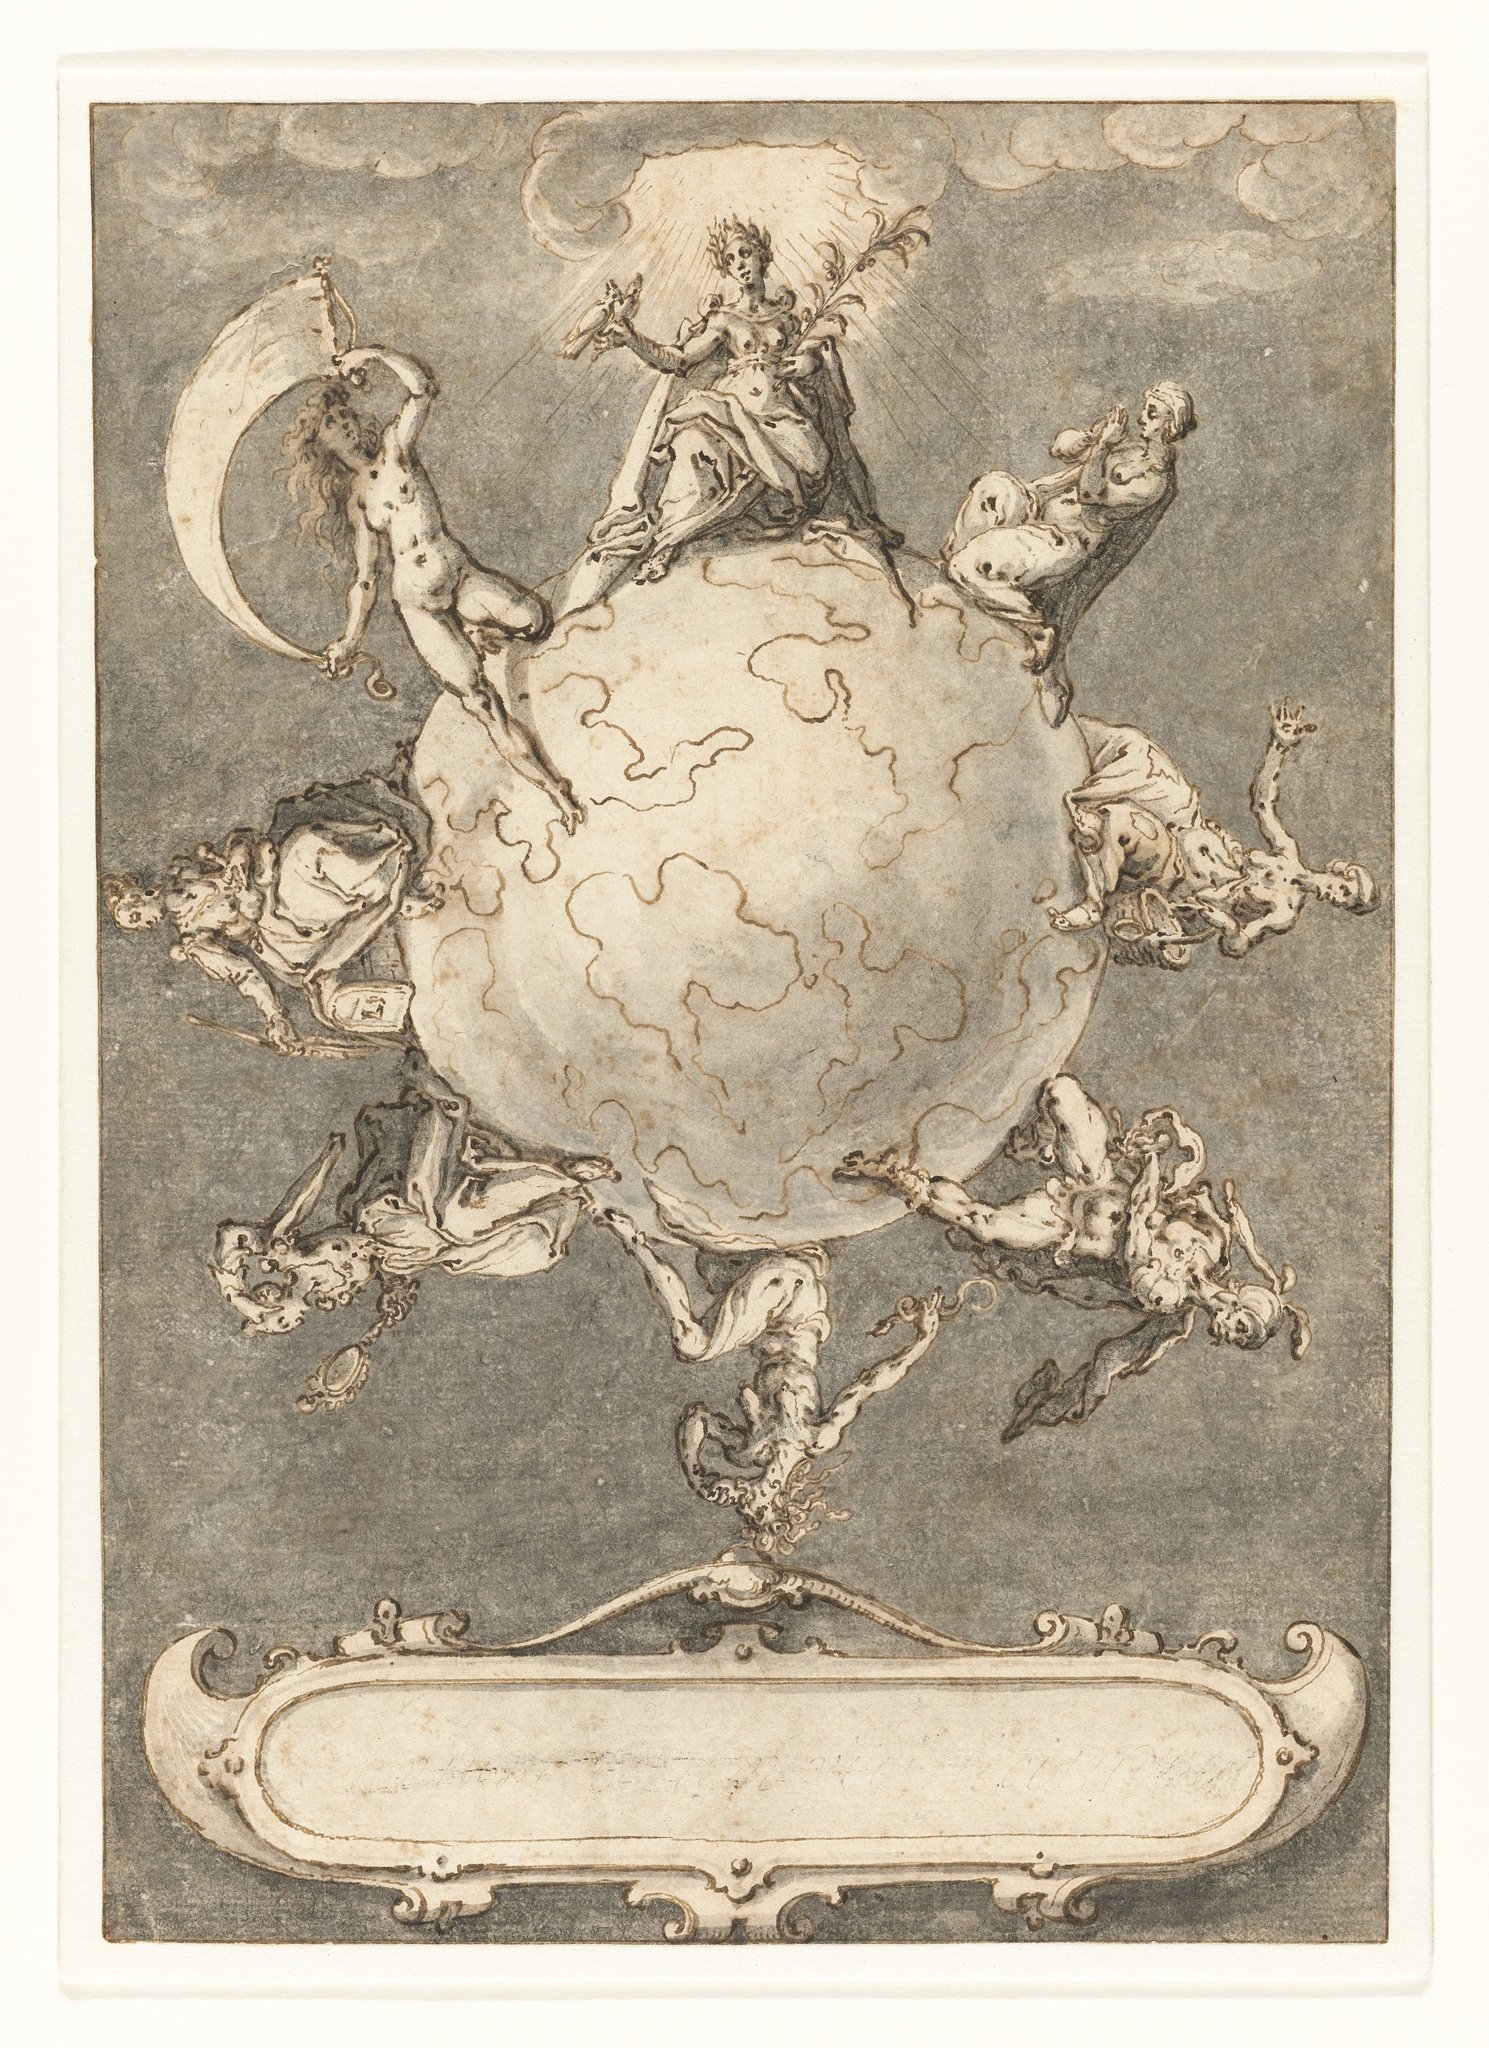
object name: drawing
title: Design for the Last Print in the Series Omnium rerum vicissitudo est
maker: jacques de gheyn (ii)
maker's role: painter, print maker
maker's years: 1565-1629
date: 1596-1597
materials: ink, paper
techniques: brush, pen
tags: turn of fate, wheel of fortune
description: The message of this print series is that existence unfolds in a fixed order, and when complete the cycle begins anew. The personifications around the globe make this clear: Peace is at the top, followed at the left by Fortune, then Wealth, Pride, Envy, War, Poverty, and Piety. Notice that this is counter-clockwise: after all, the drawing is the mirror image of the print.